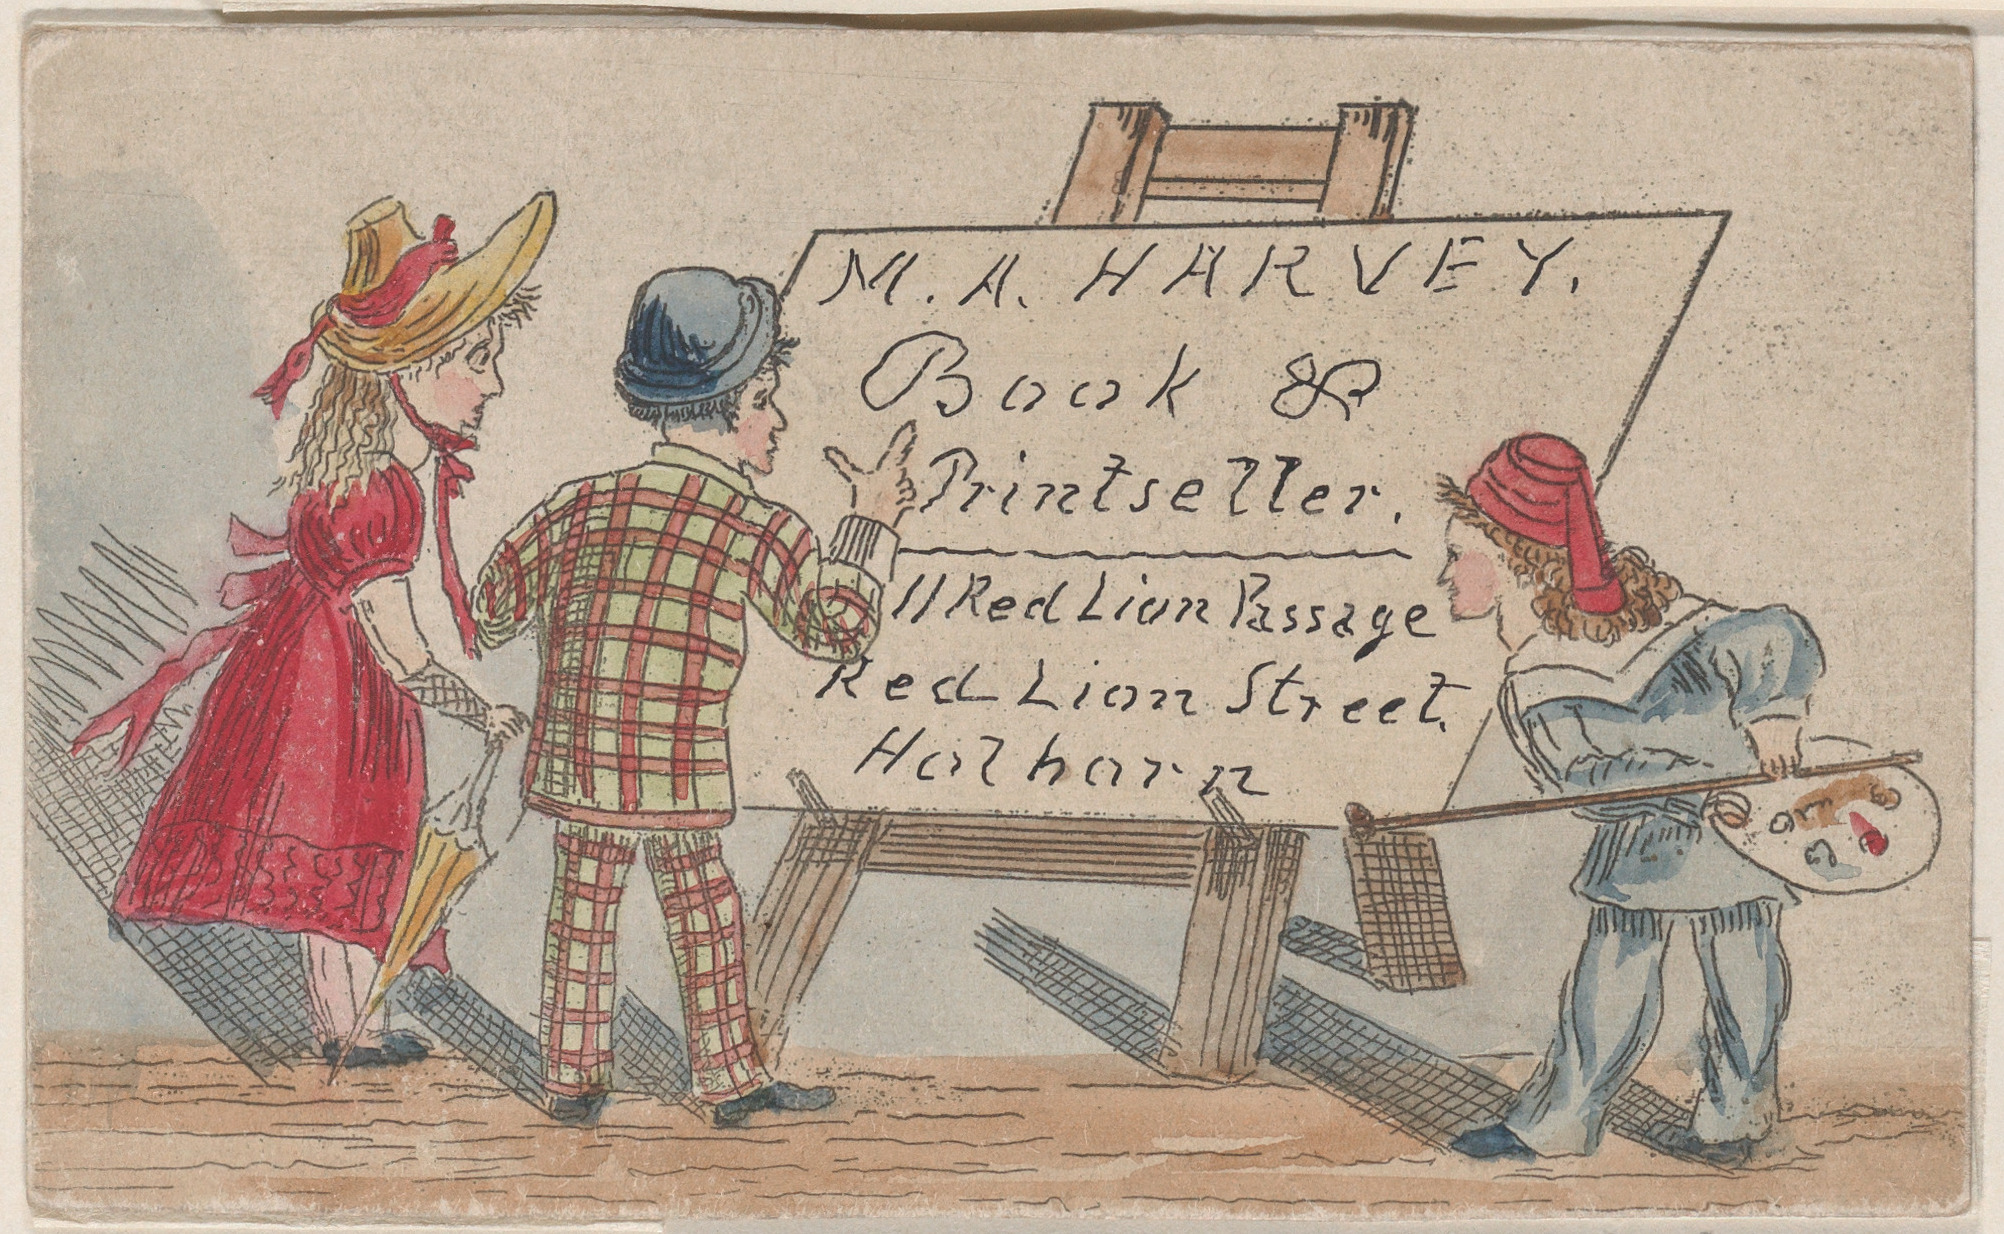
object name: print, trade card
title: Trade card for M.A. Harvey, Book and Printseller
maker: anonymous, british, 20th century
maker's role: artist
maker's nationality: british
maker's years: 1900-1999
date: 1701-1800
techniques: engraving